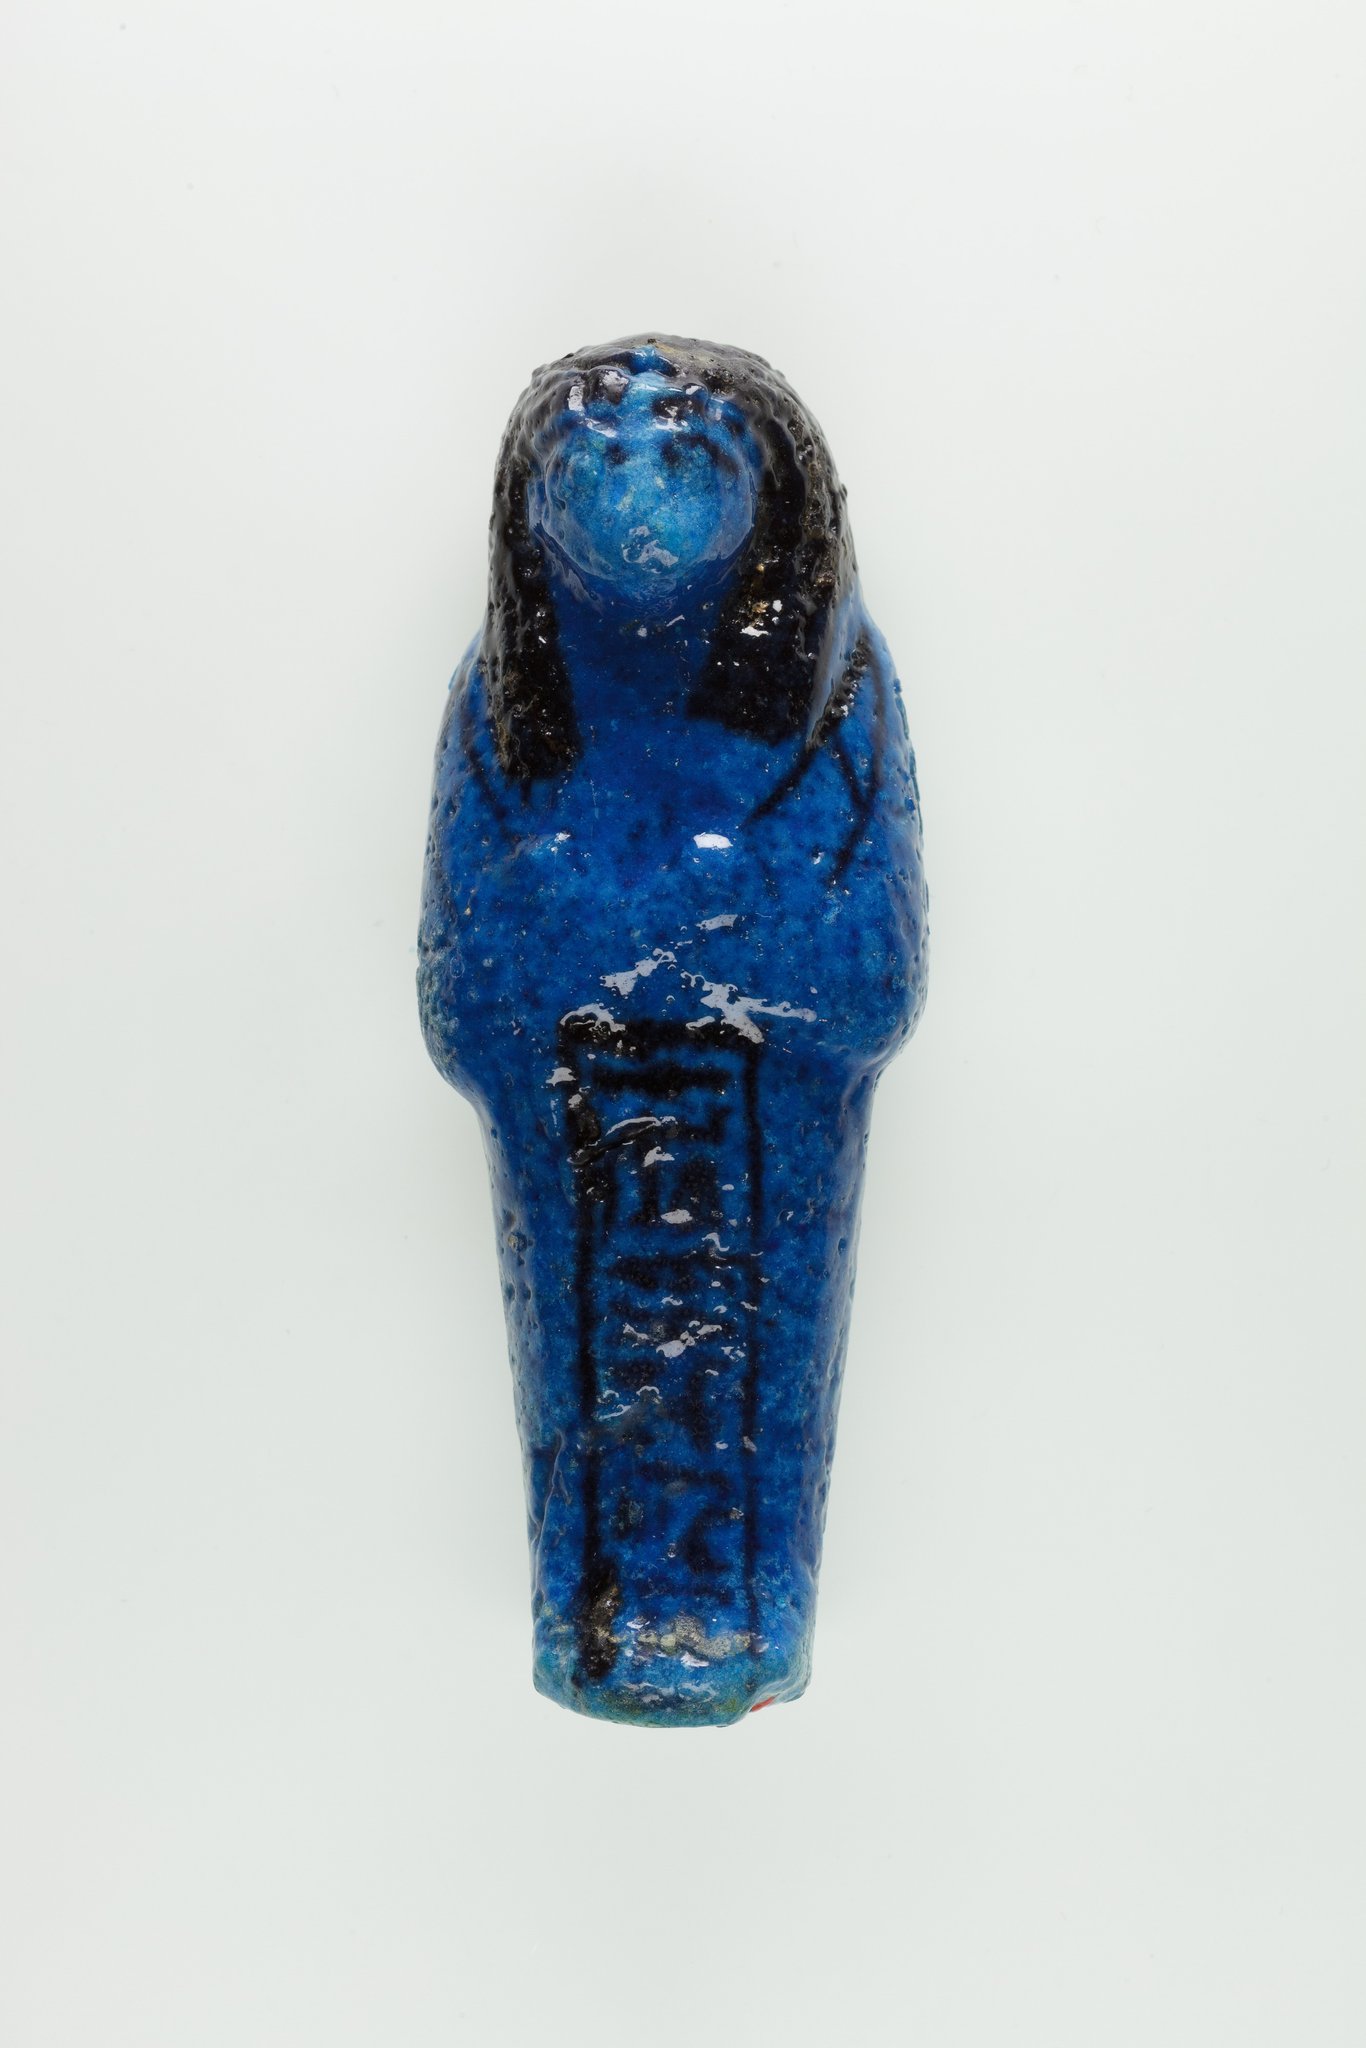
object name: shabti, worker, nauny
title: Worker Shabti of Nauny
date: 1050 BCE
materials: faience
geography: egypt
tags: hieroglyphs